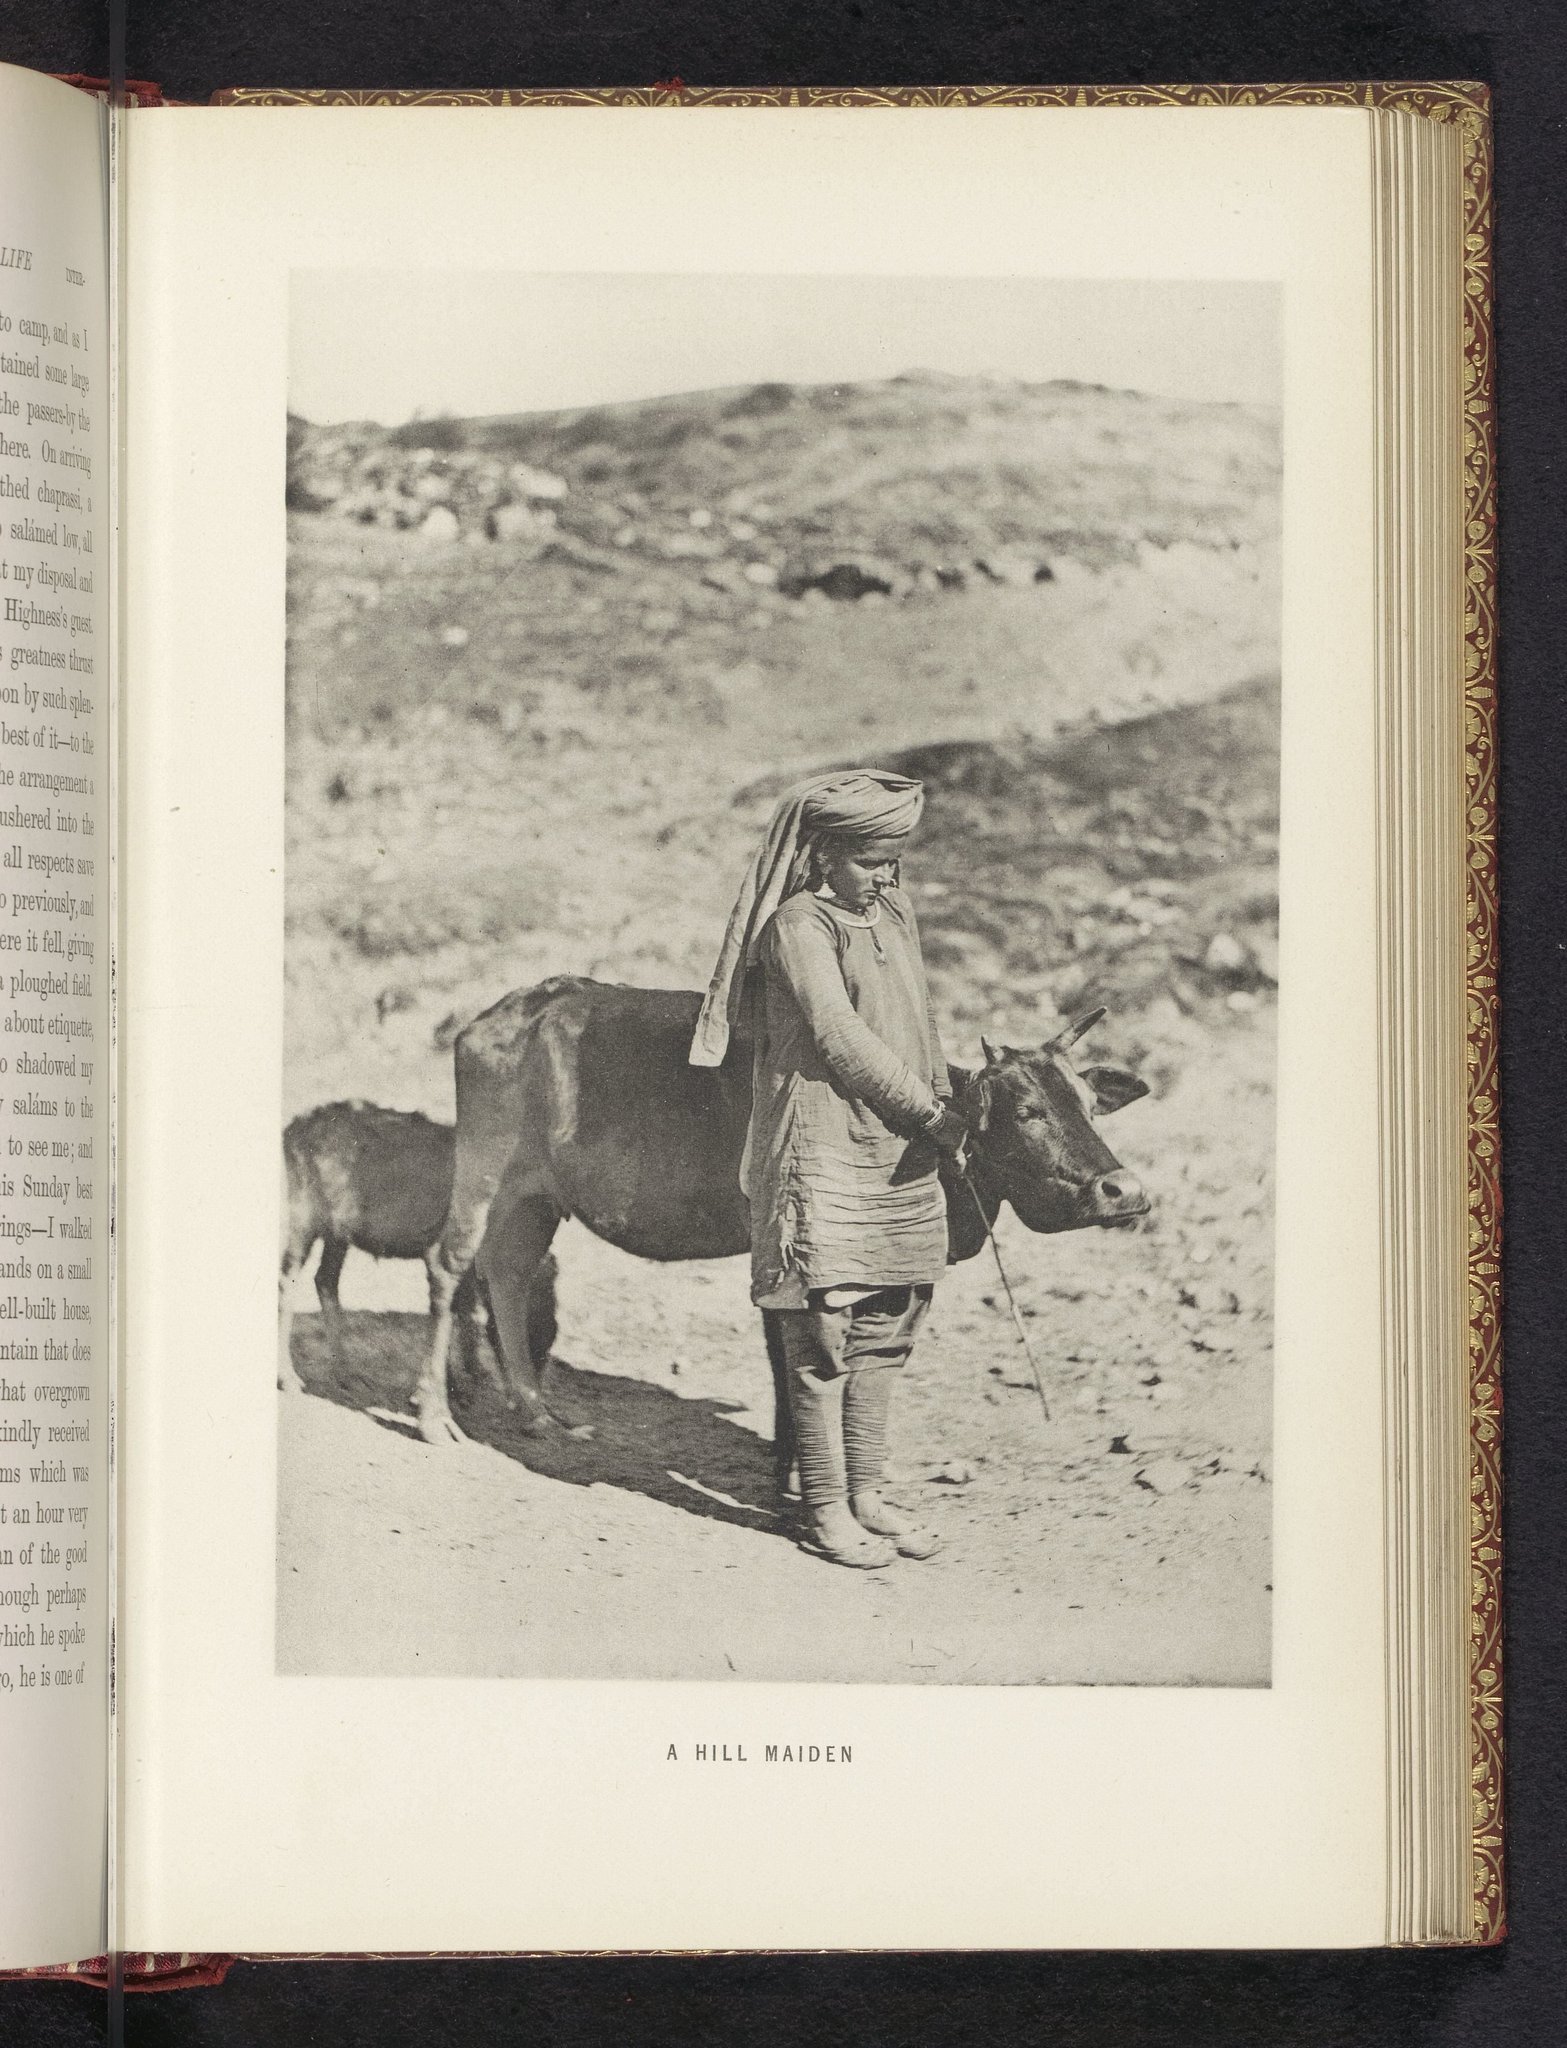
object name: photomechanical print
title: Girl with a cow, Himachal Pradesh, India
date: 1890-1895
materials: paper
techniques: photograph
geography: himachal pradesh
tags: adolescent, young woman, maiden, cow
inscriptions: caption: ‘A HILL MAIDEN’